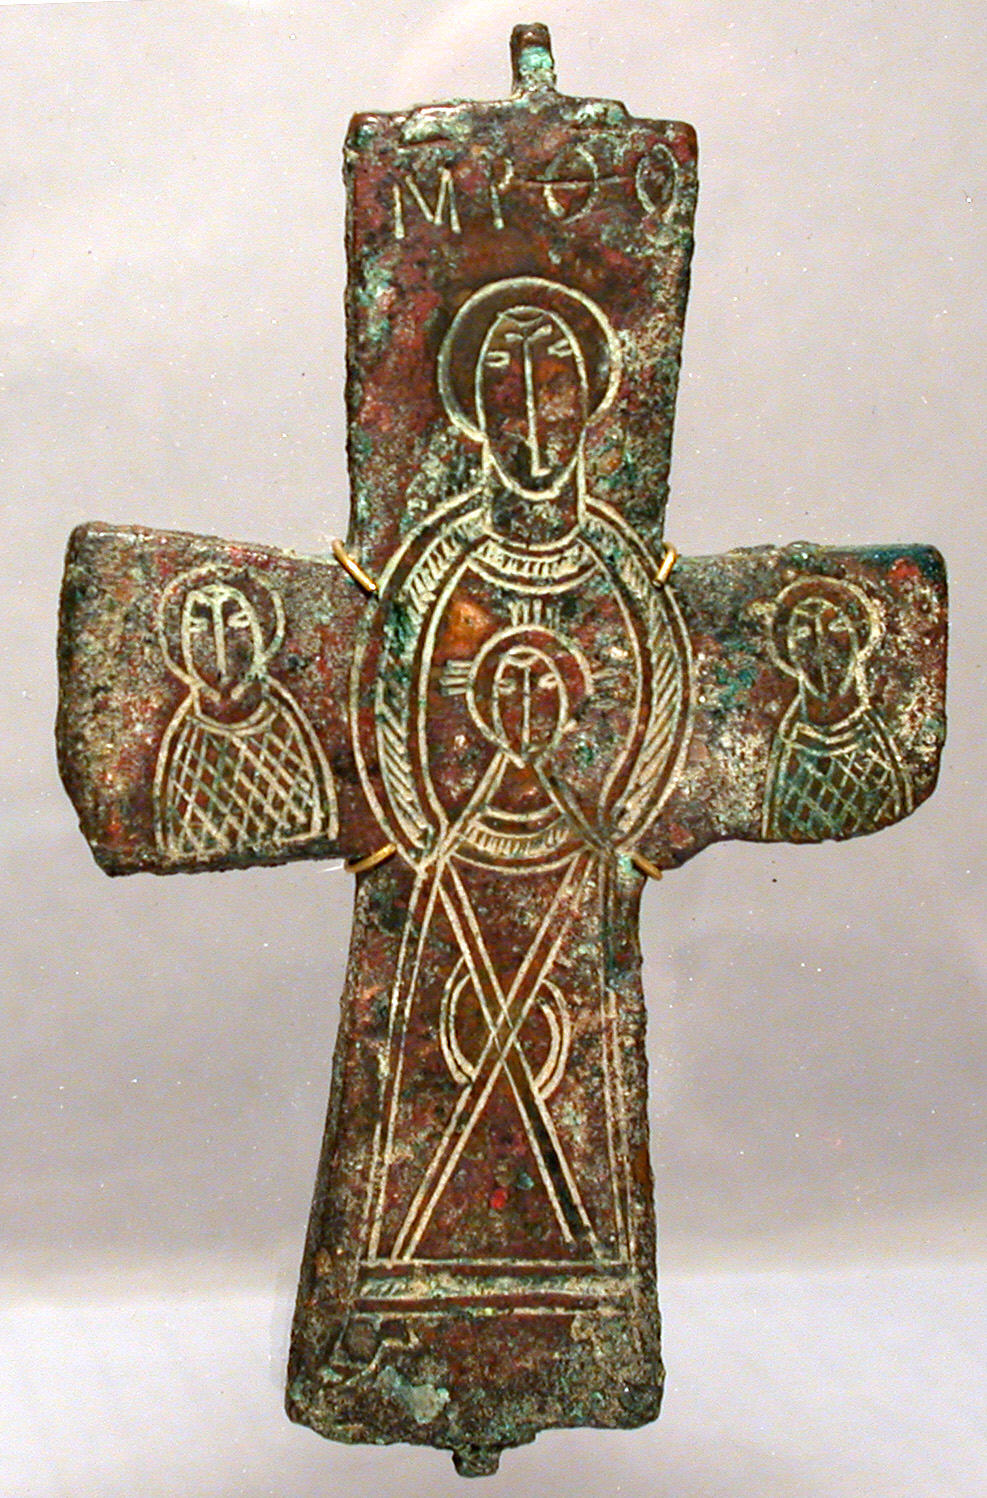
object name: reliquary cross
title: Half of a Pendant Reliquary Cross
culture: byzantine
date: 1001-1100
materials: copper alloy